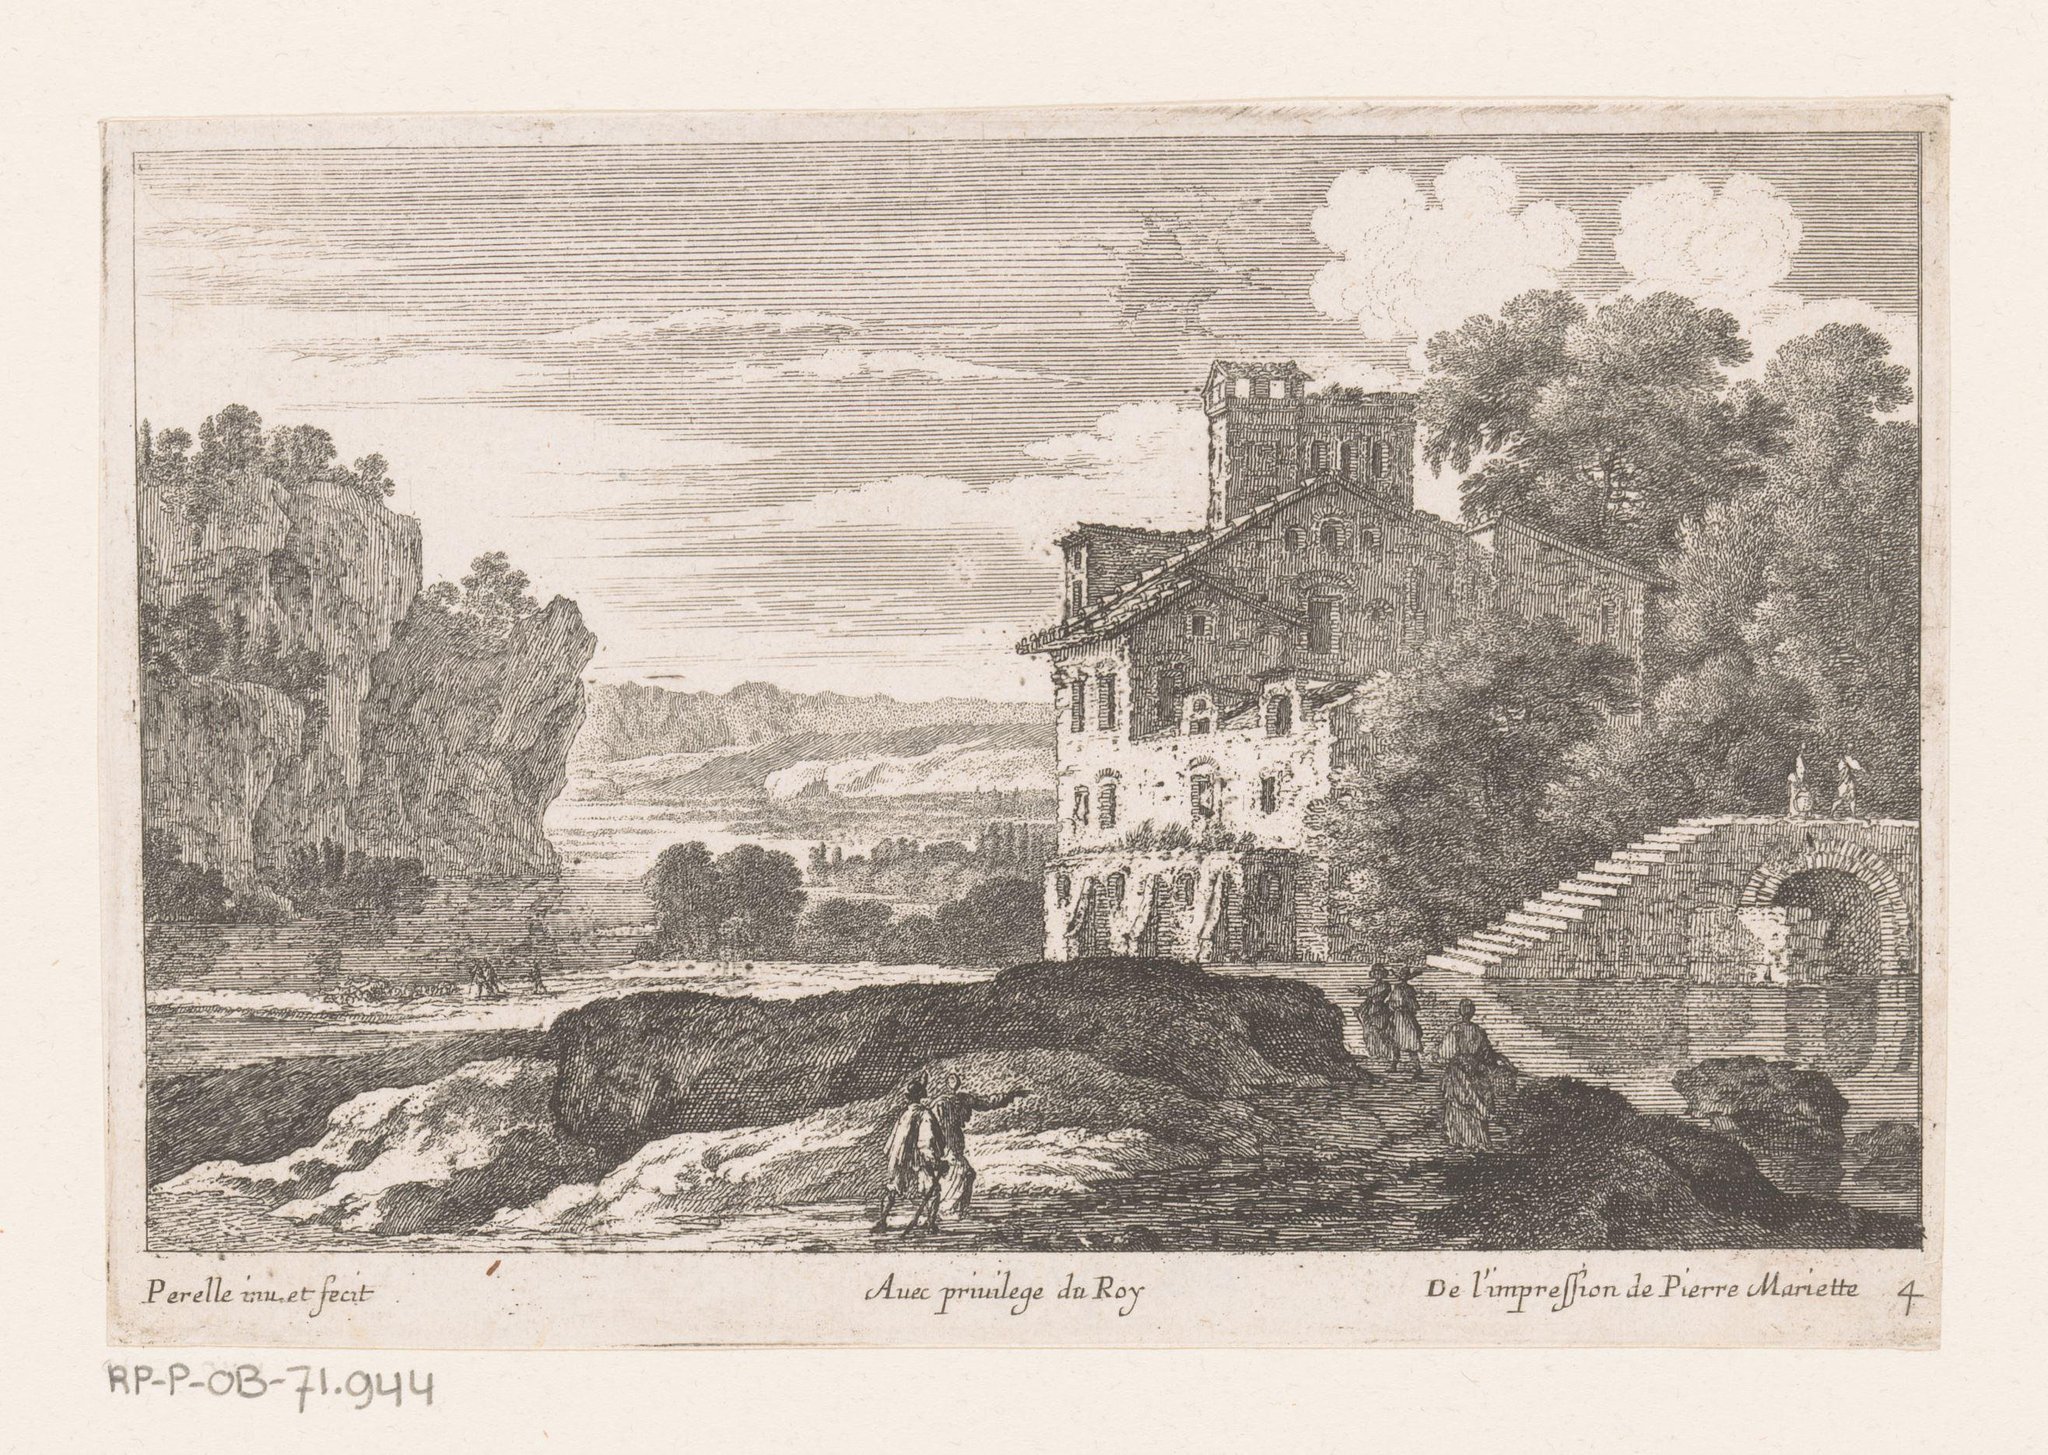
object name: print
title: Diverse landschappen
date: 1613-1695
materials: paper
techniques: etching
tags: landscapes with waters, waterscapes, seascapes (in the temperate zone), villa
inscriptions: collector's mark: Lugt 240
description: Prenten met het signatuur 'Perelle' kunnen zowel door vader Gabriel als door zonen Nicolas en Adam gemaakt zijn.